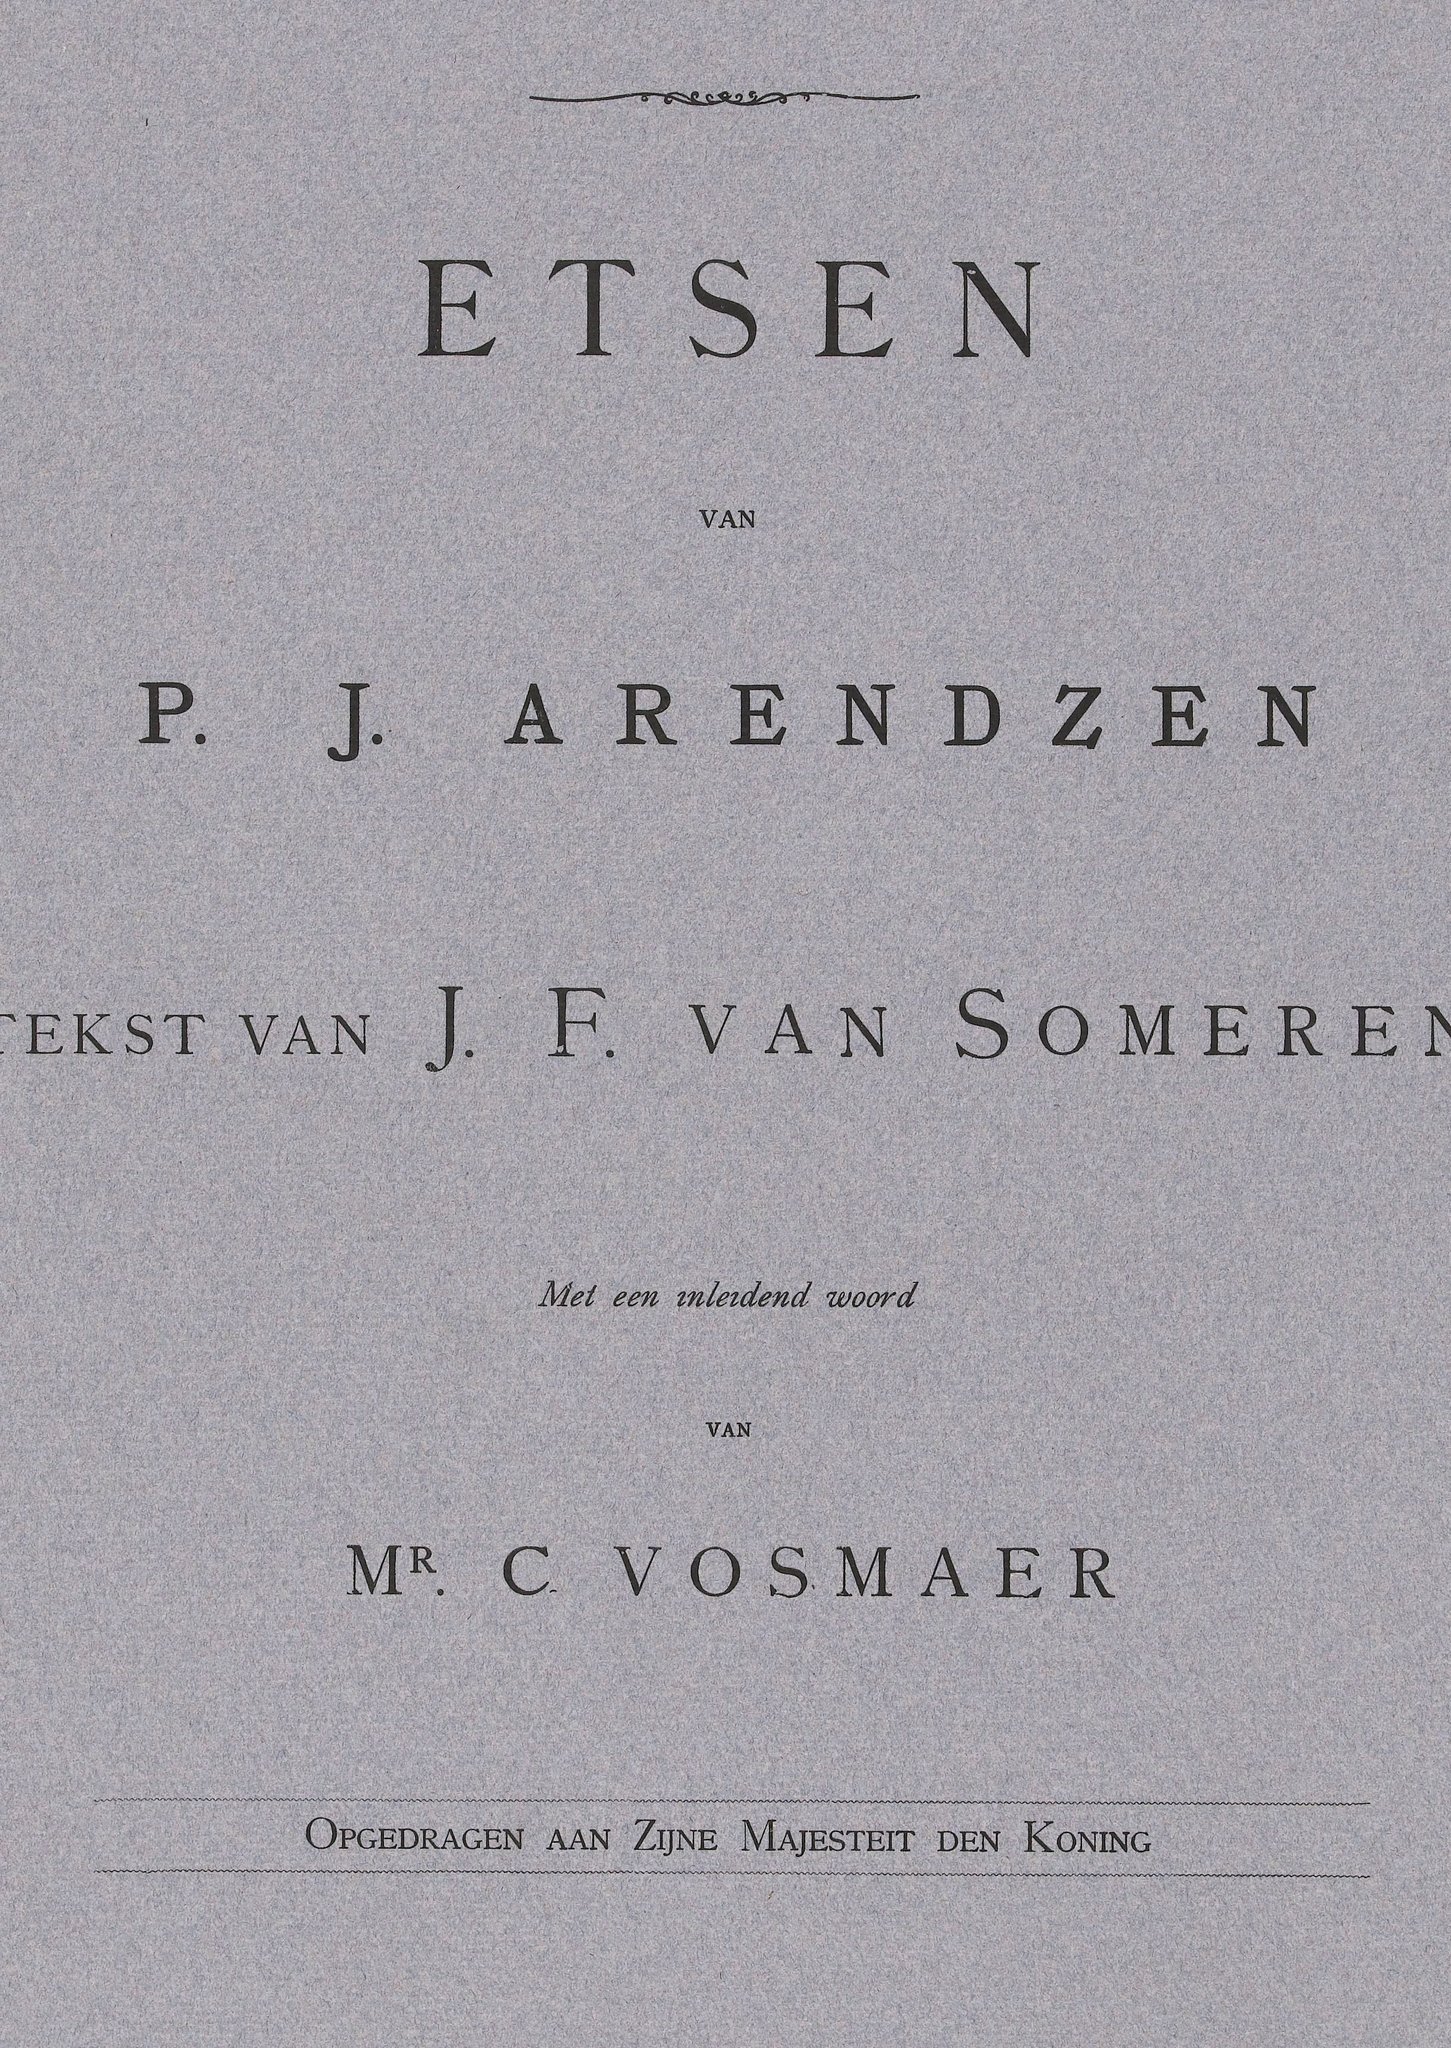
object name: wrapper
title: Omslag voor "Moderne Kunst in Nederland. Etsen van P.J. Arendzen, tekst van J.F. Someren", aflevering 29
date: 1786-1787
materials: paper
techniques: letterpress printing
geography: amsterdam